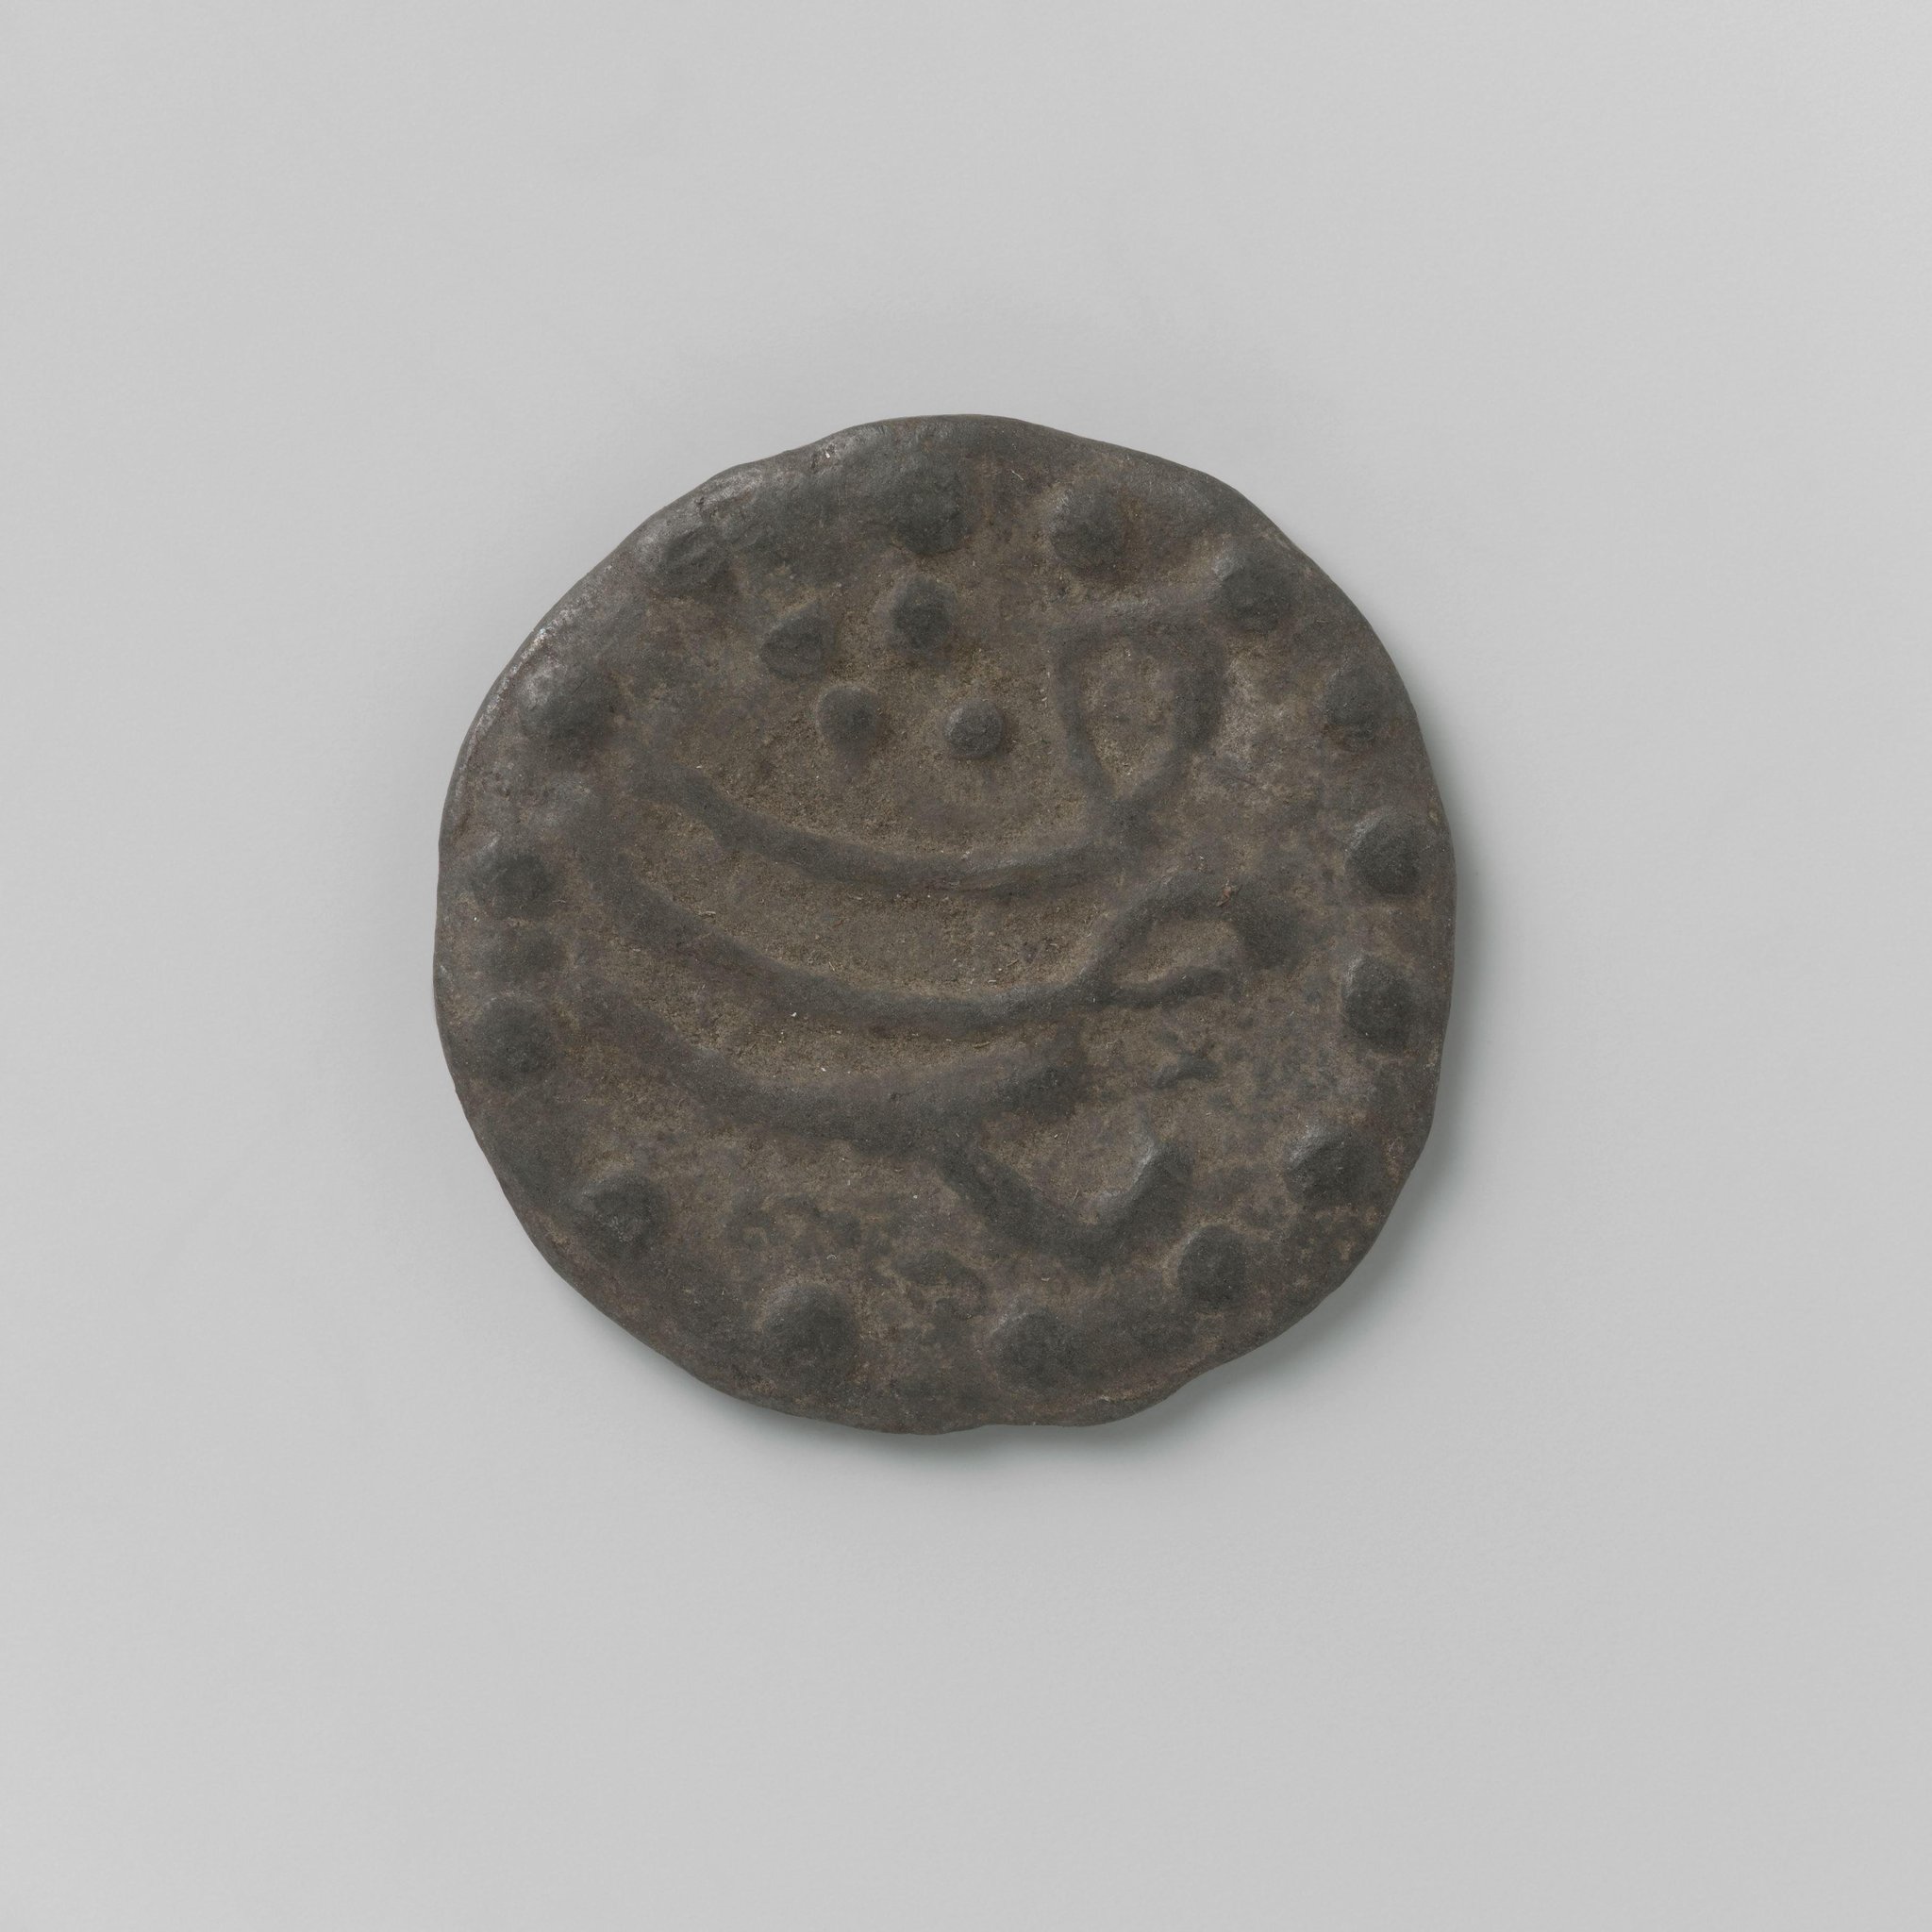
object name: coin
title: Kasja van sultan Mohammed van Atjeh, Sumatra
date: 1824-1838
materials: tin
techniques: casting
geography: aceh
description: Tinnen munt. Voorzijde: drieregelig opschrift in Arabische lettertekens. Keerzijde: drieregelig opschrift in Arabische lettertekens.